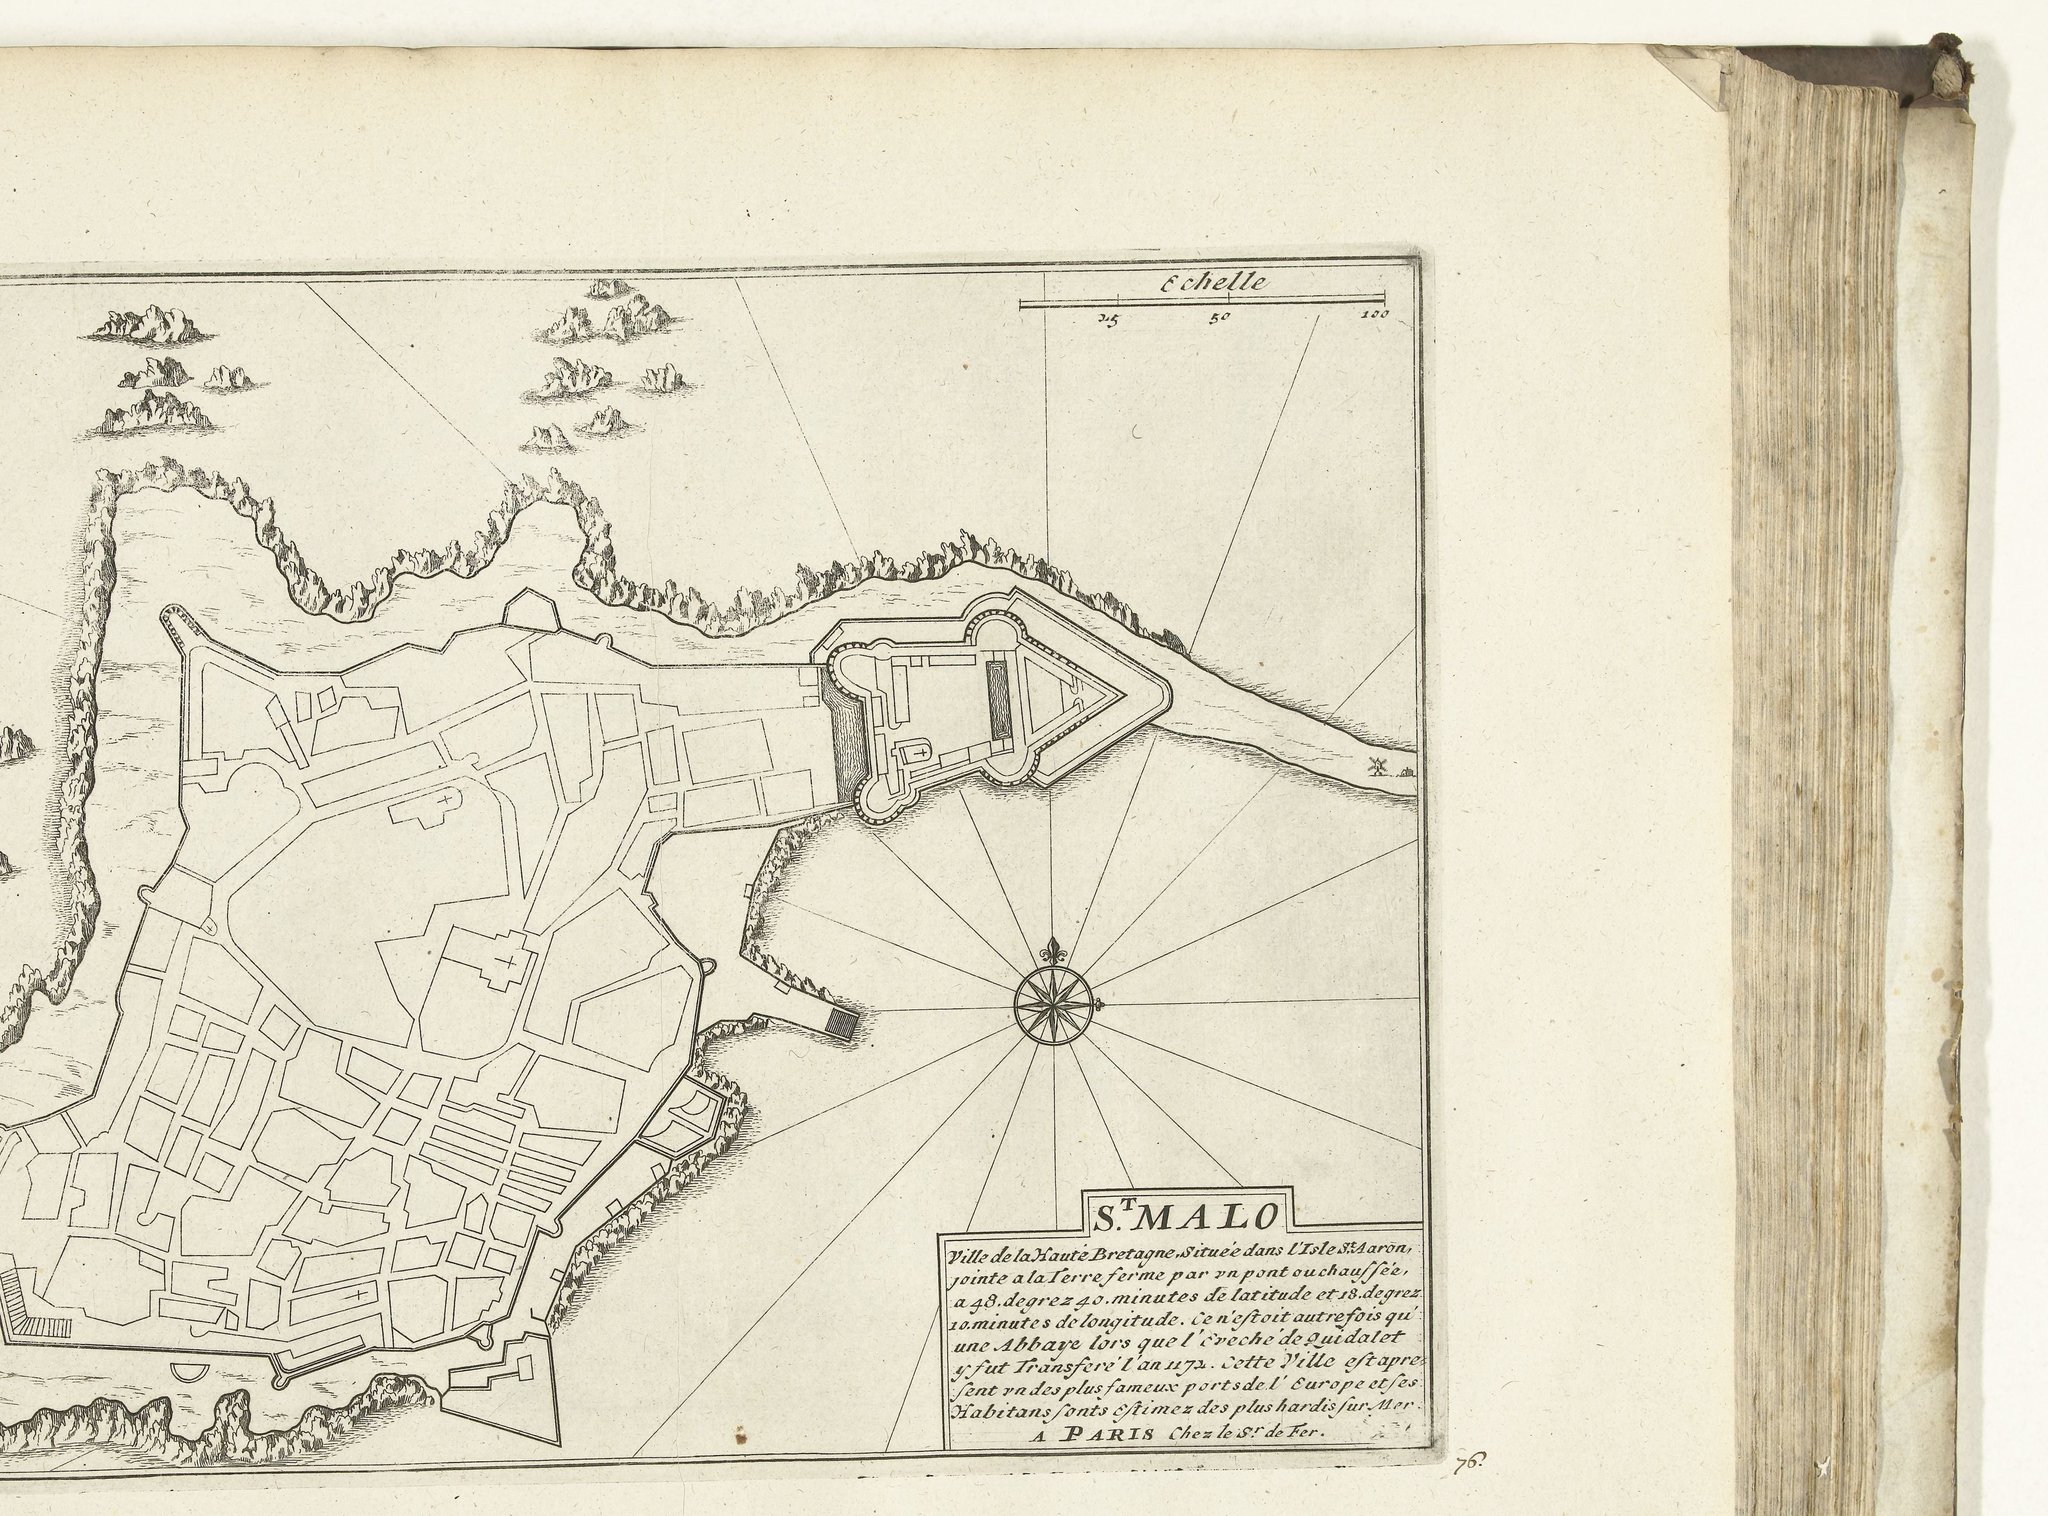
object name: print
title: Les Forces de l'Europe, Asie, Afrique et Amerique (...) Comme aussi les Cartes des Côtes de France et d'Espagne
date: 1726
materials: paper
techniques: etching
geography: paris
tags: fortress, maps of cities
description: Plattegrond van de versterkingen om de Franse stad Saint-Malo. Plaat nr. 76 in deel IV van het prentwerk: Les Forces de l'Europe, Asie, Afrique et Amerique ... Comme aussi les Cartes des Côtes de France et d'Espagne uit 1726, dit eerste deel met 238 met de hand genummerde platen van vermaarde sterke steden en vestingen in het kader van de Spaanse Successieoorlog 1701-1713. Voor het merendeel zijn deze platen gekopieerd naar de anonieme Franse platen van vermaarde sterke steden en vestingen: in Les forces de l'Europe en in: Le theatre de la guerre, dans les Pays-Bas, beide oorspronkelijk uitgegeven door Nicolas de Fer te Parijs (1693-1697) in het kader van de Negenjarige Oorlog. Titel en opschriften in het Frans. Rechtsonder sporen van het weggepolijste nummer: 231.